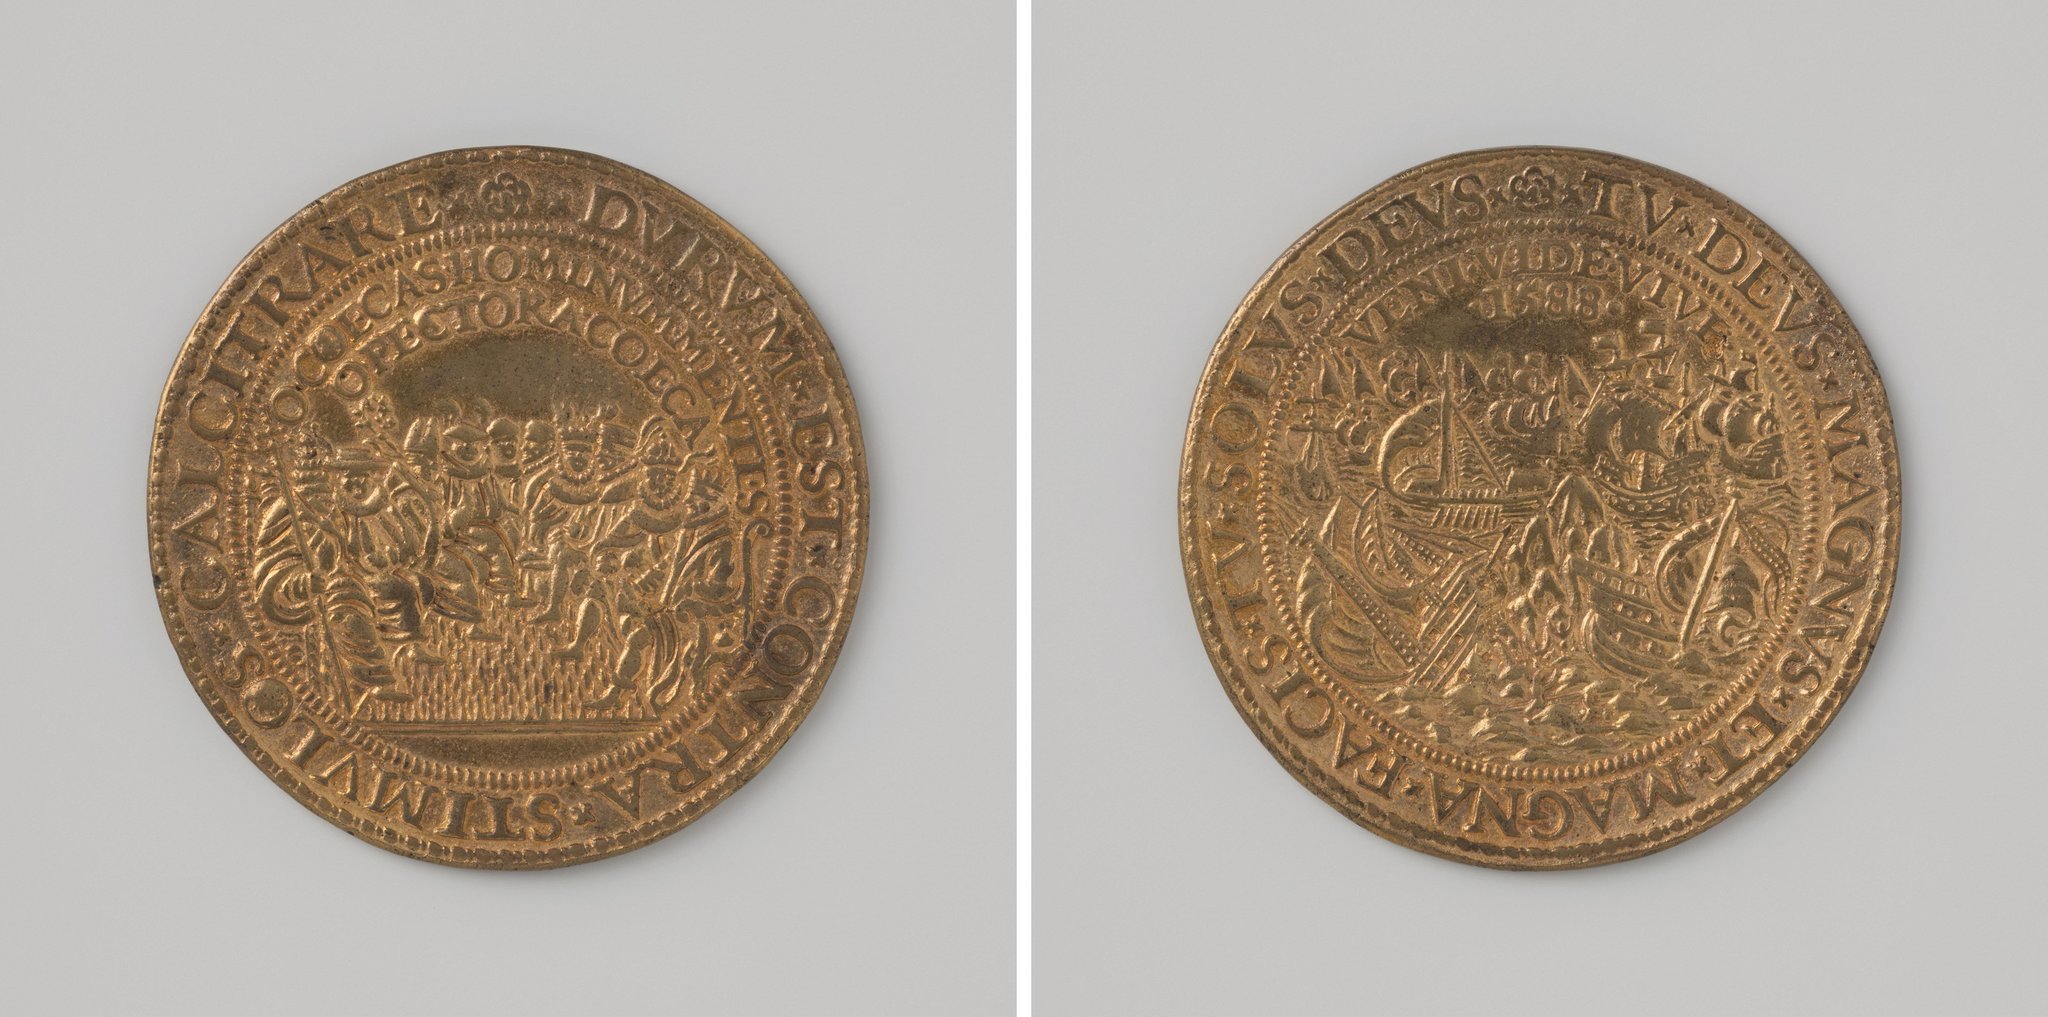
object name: history medal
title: Vernietiging van de Armada / Onoverwinnelijke Vloot 1588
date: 1588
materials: brass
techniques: casting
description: Verguld zilveren penning, op de voorzijde Paus en katholieke vorsten op een vloer bezet met stekels, met dubbel omschrift, op de keerzijde Spaanse schepen die schipbreuk lijden, met dubbel omschrift.